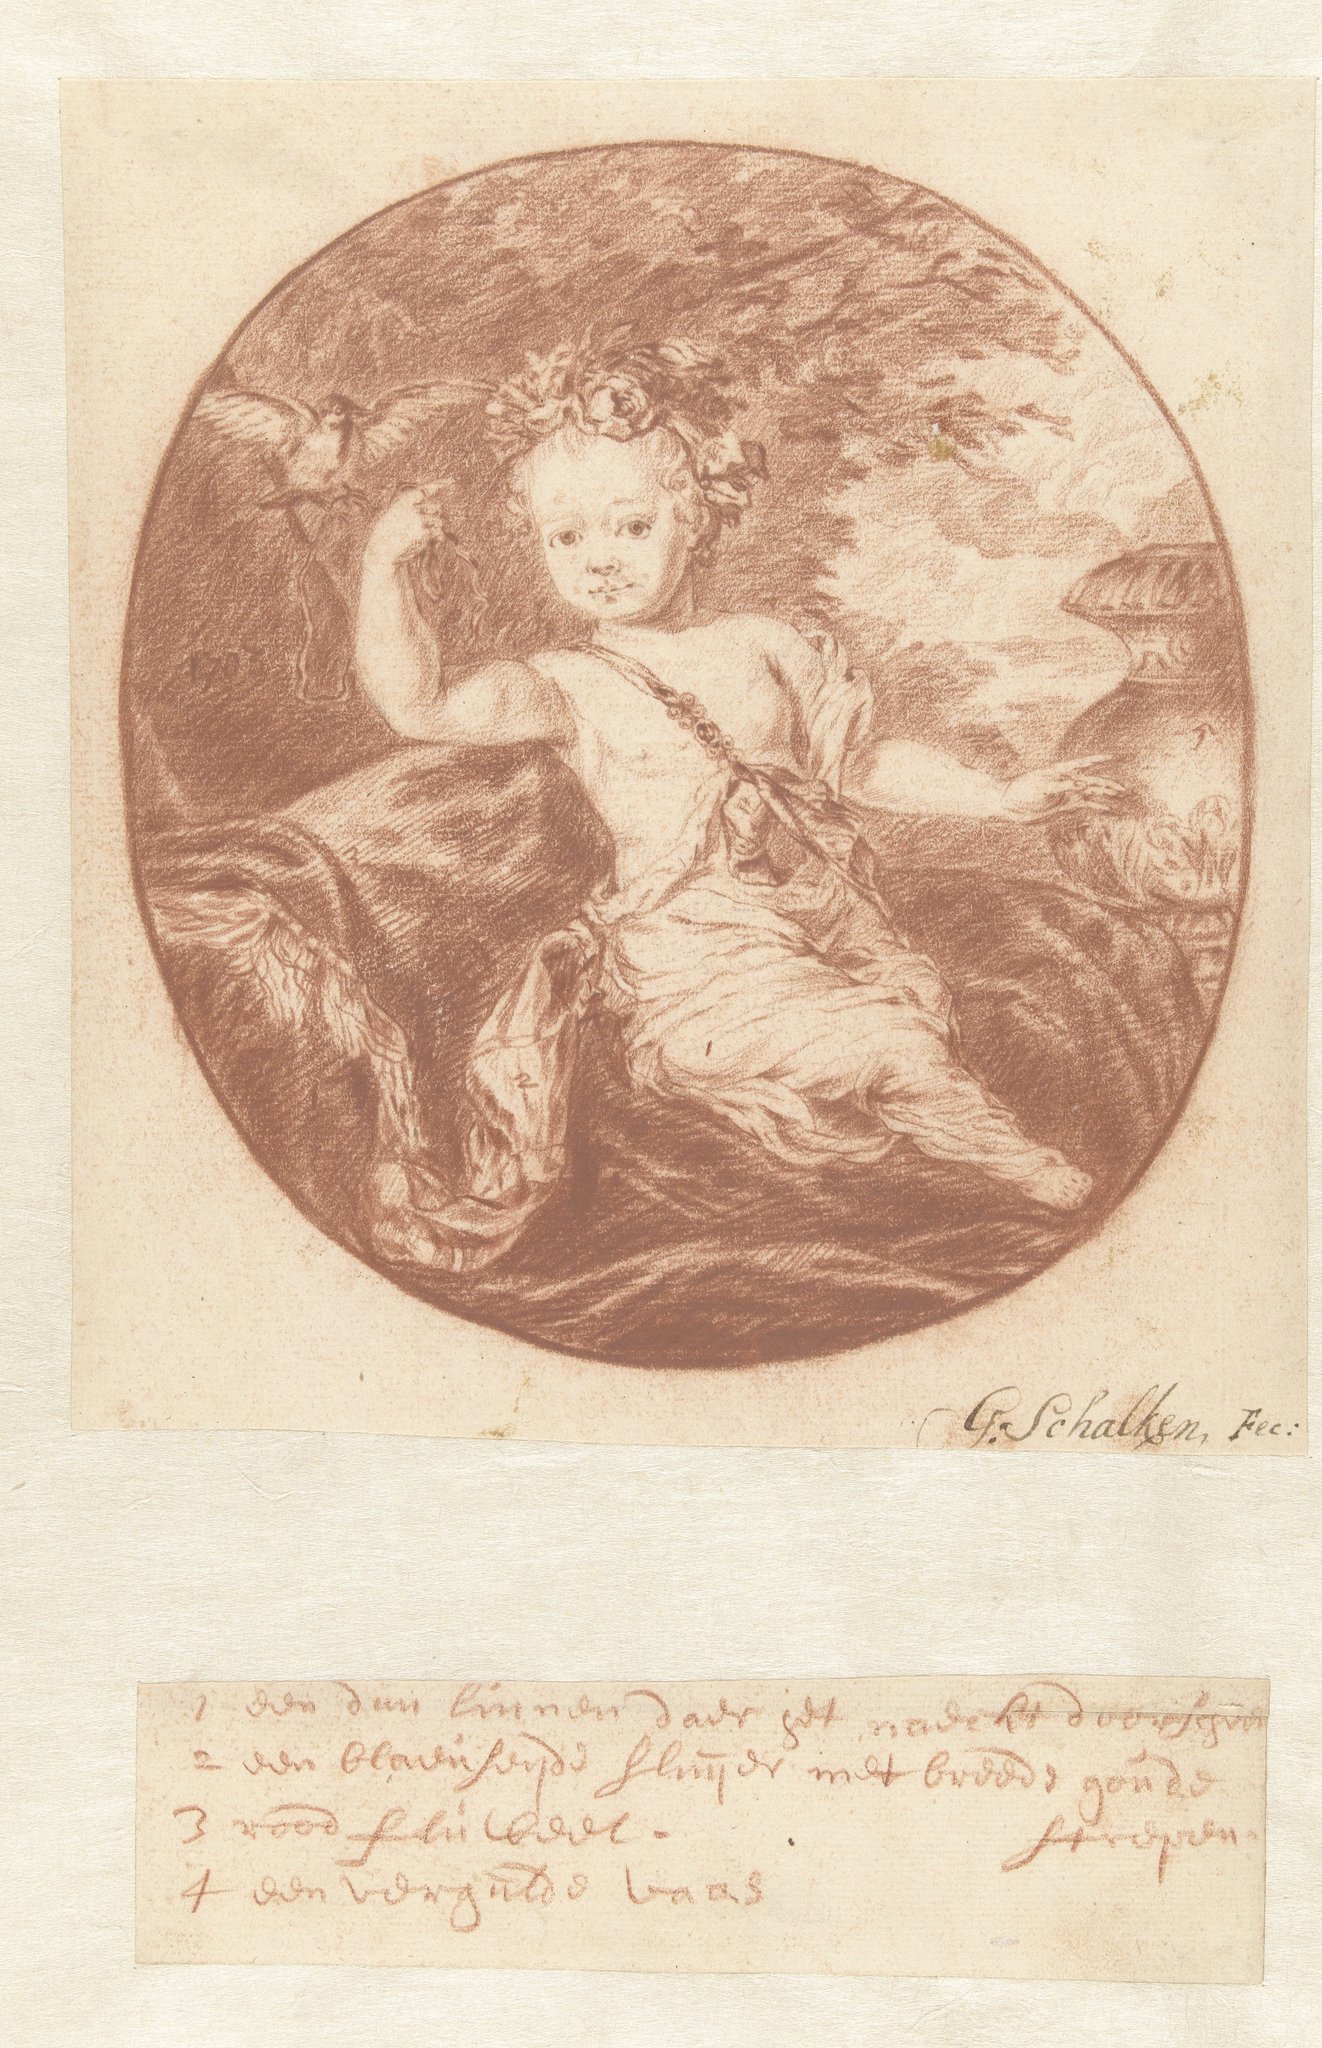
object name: drawing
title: Portret van een zittend kind met een vogeltje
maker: godfried schalcken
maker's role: draughtsman, painter, print maker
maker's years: 1643-1706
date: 1703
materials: chalk, paper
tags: birds, anonymous historical person portrayed alone, child, taming, domestication of animals; tamed or domesticated animal